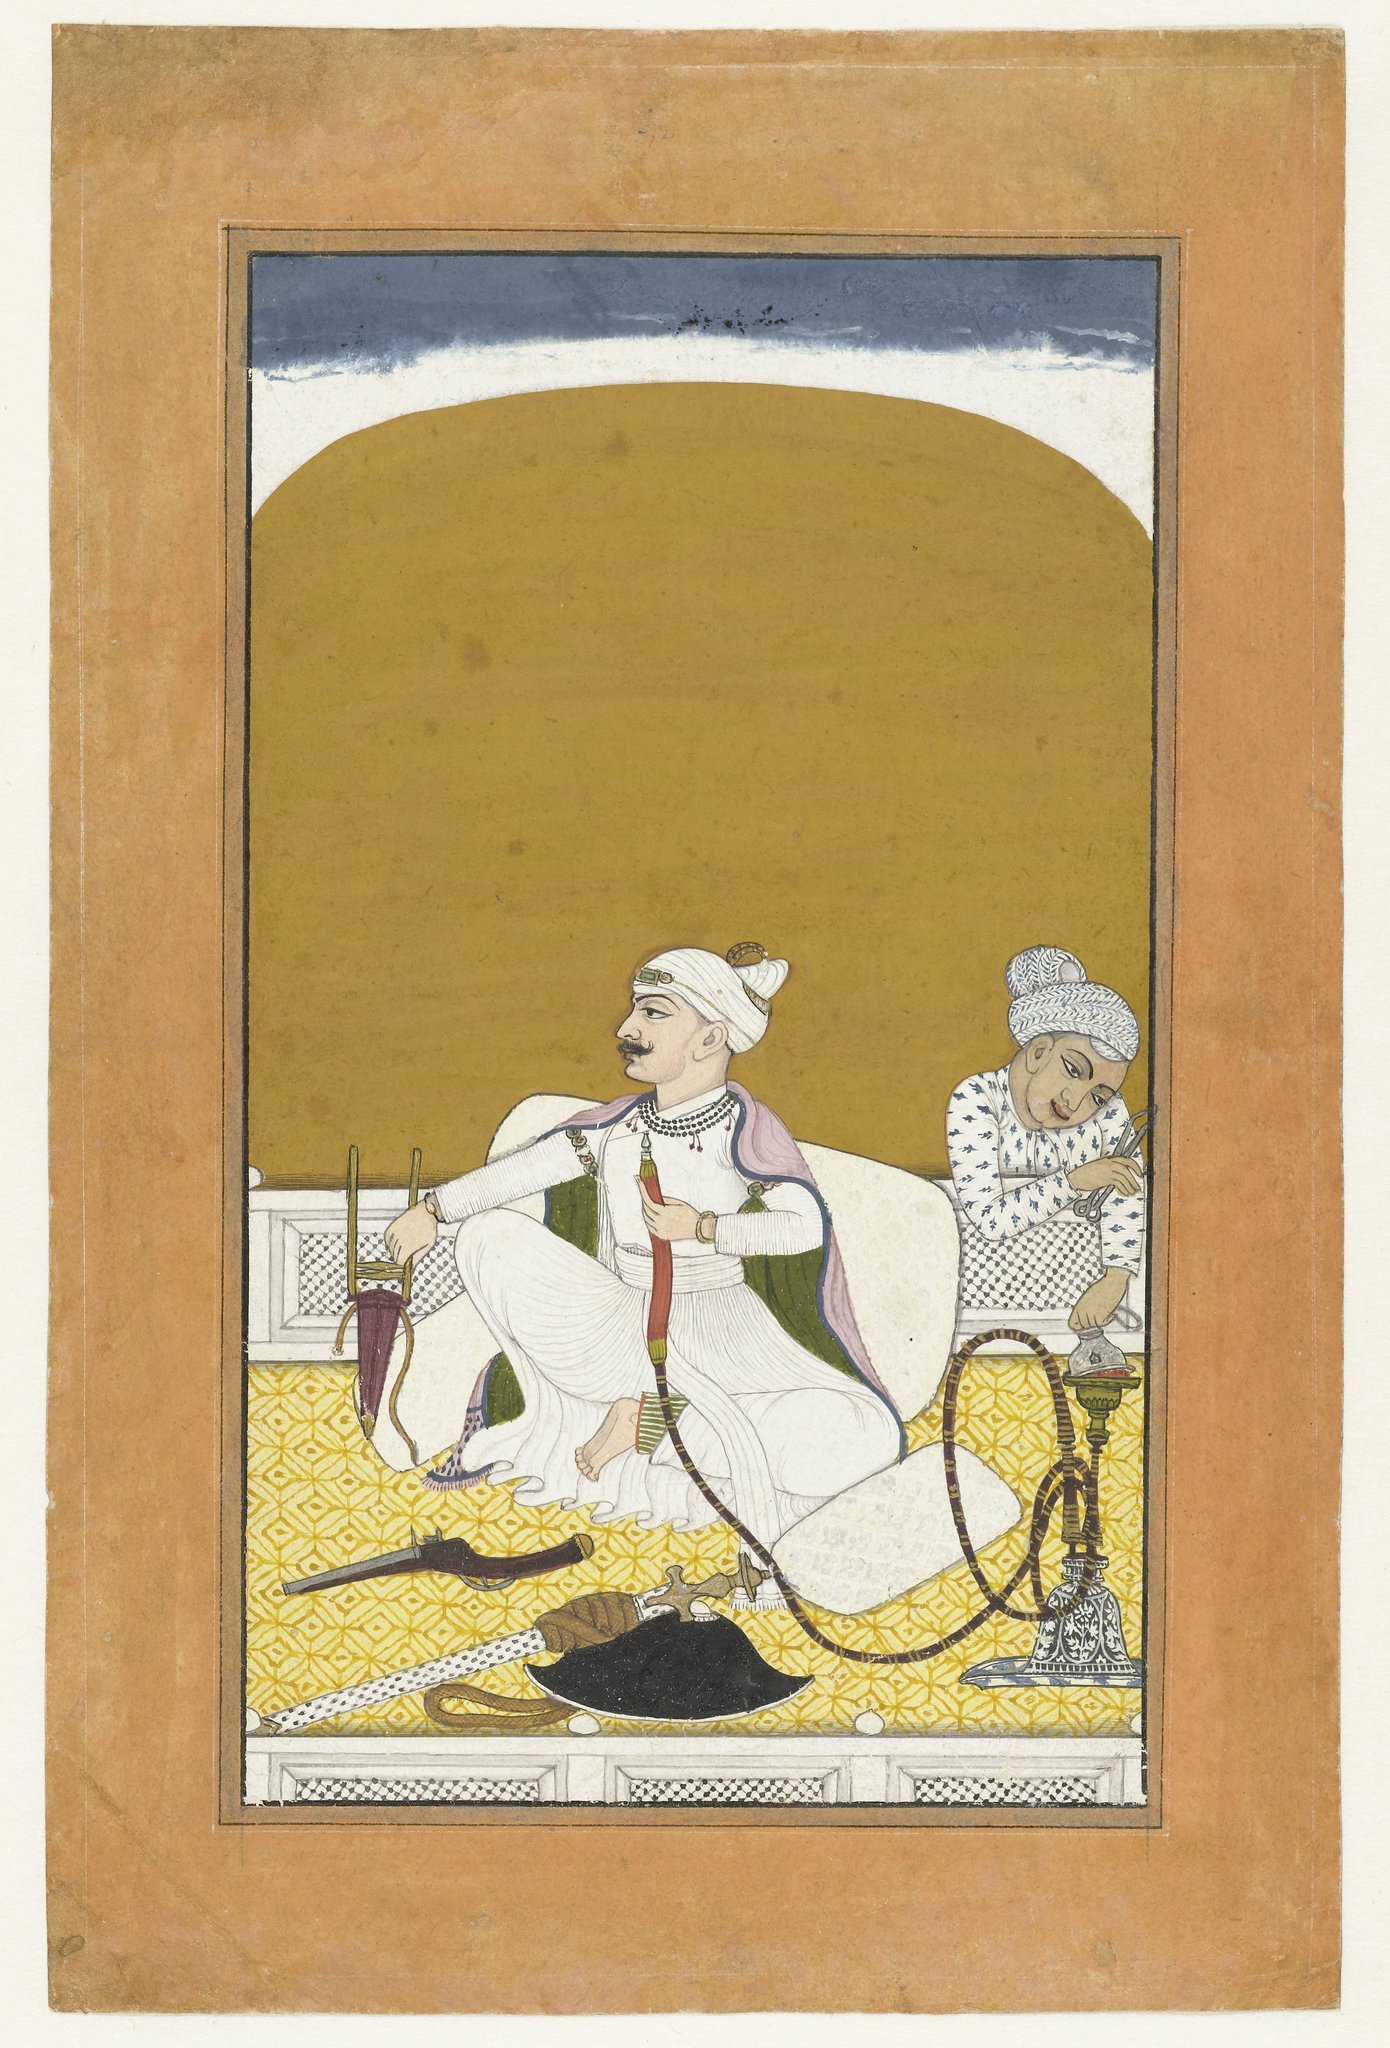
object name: indian miniature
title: Portret van Sukhjivan Khan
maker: Anonymous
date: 1760-1770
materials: paint, gouache, paper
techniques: brush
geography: jammu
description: Portret van Sukhjivan Khan volgens opschrift op verso.